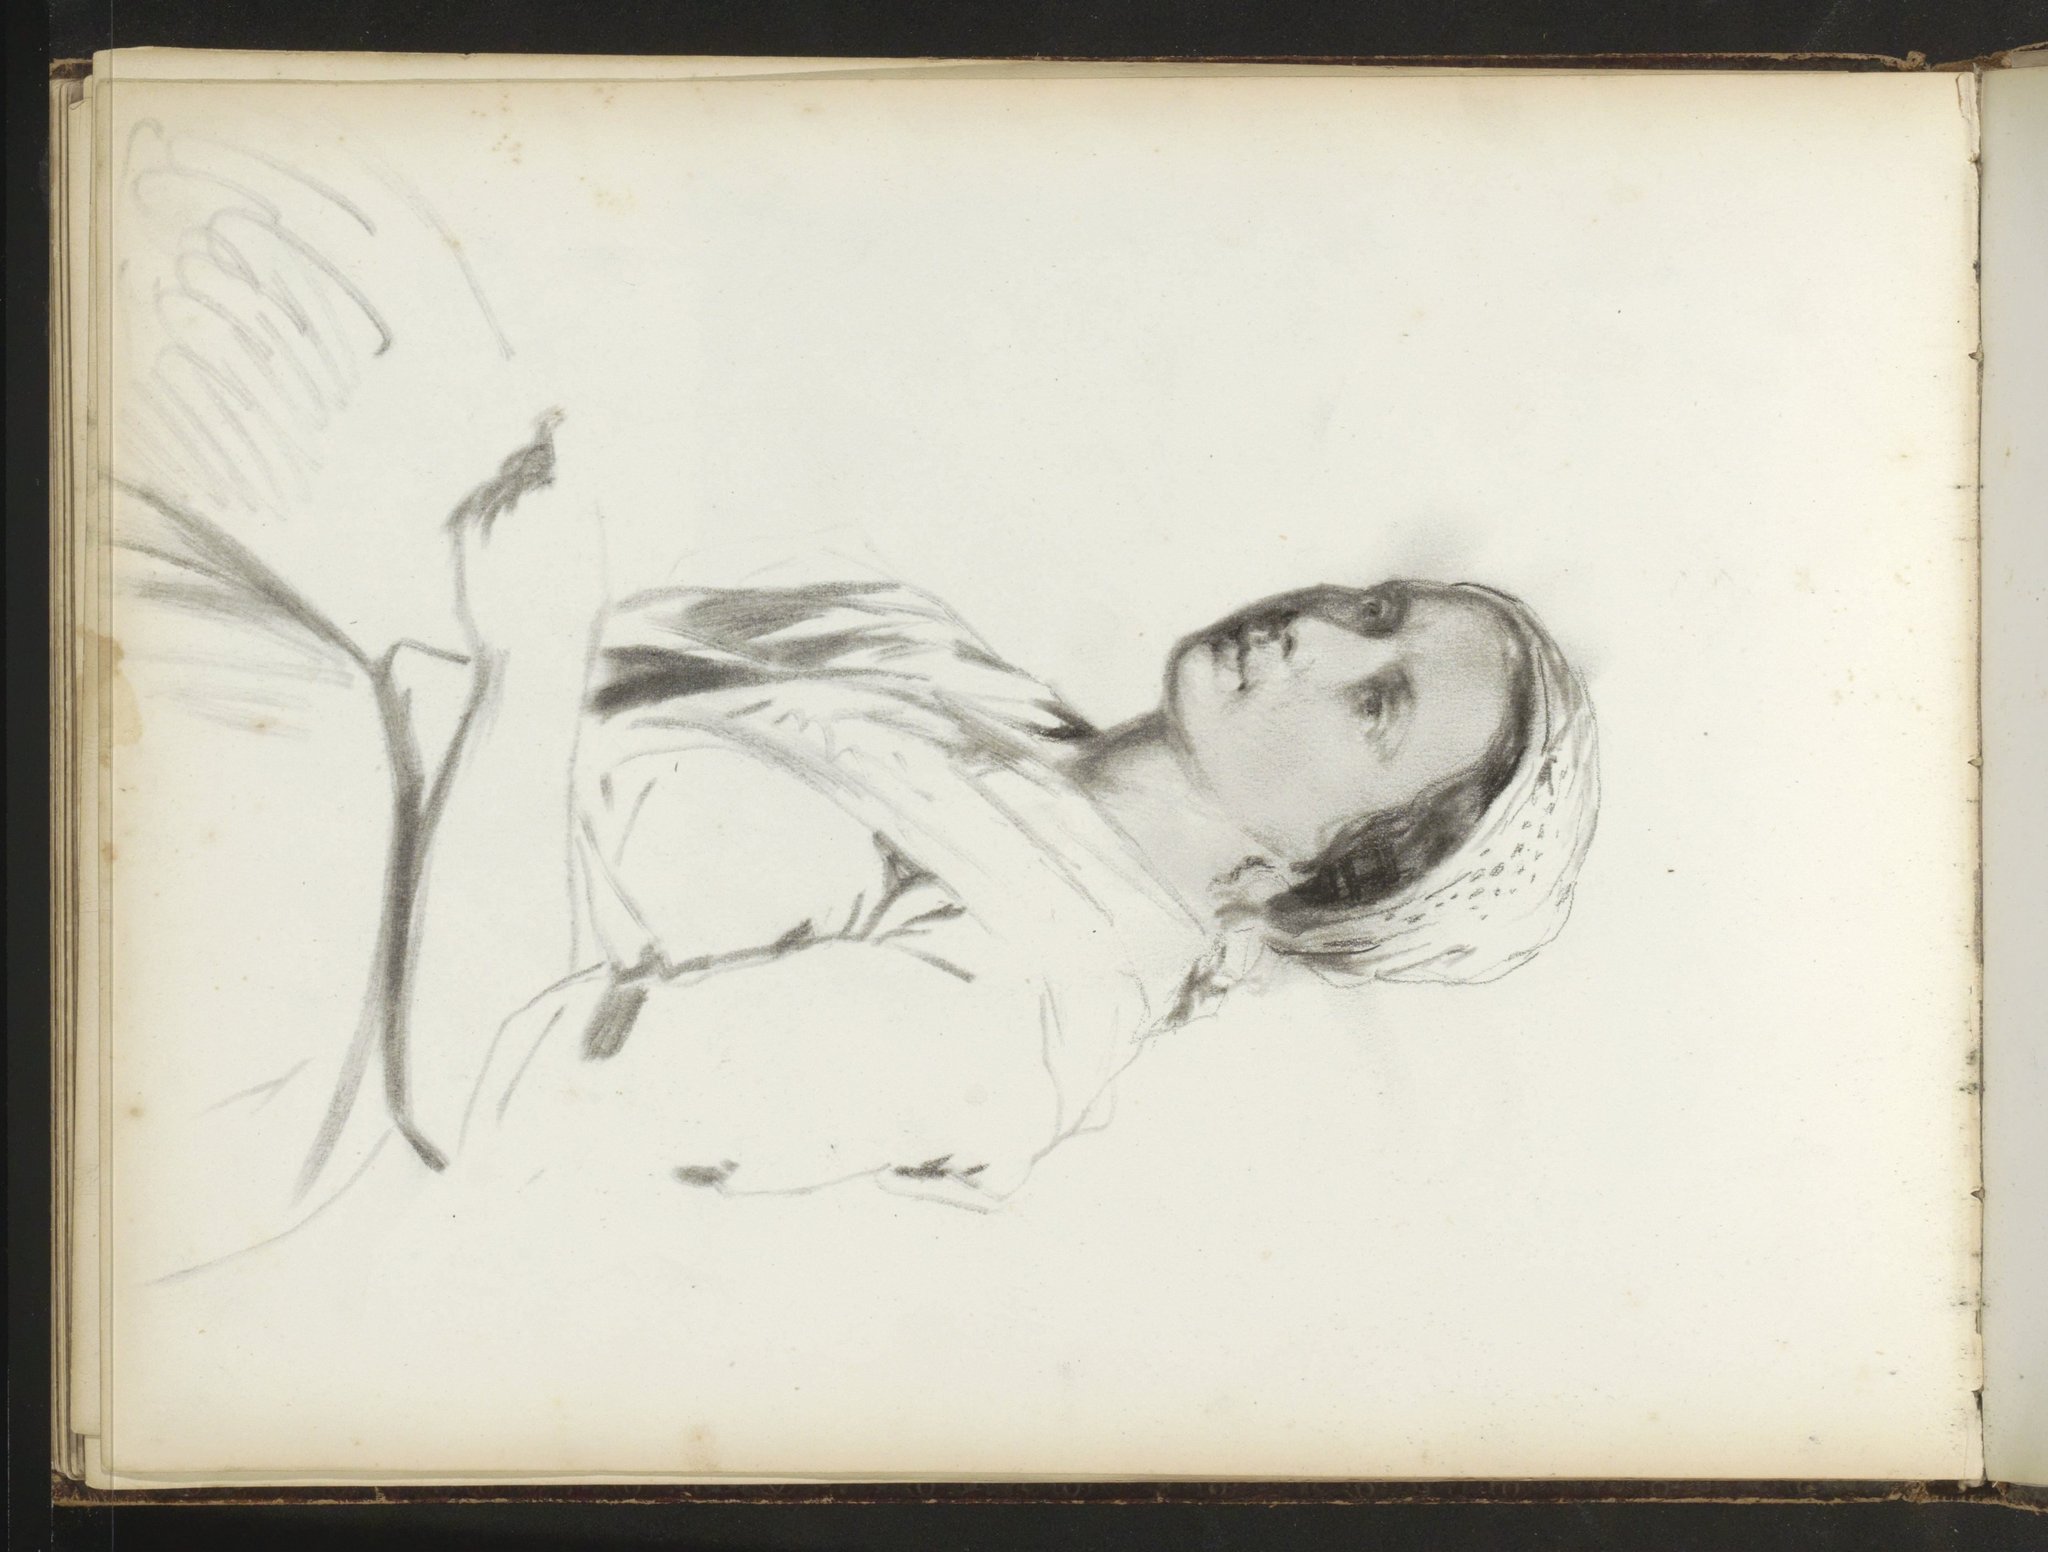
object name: sketchbook leaf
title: Vrouw met een hoofddoek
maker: reinier craeyvanger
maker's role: draughtsman, print maker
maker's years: 1812-1880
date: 1822-1880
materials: charcoal, paper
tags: standing figure, head-gear (with name)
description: Blad 35 verso uit een schetsboek met 45 bladen.